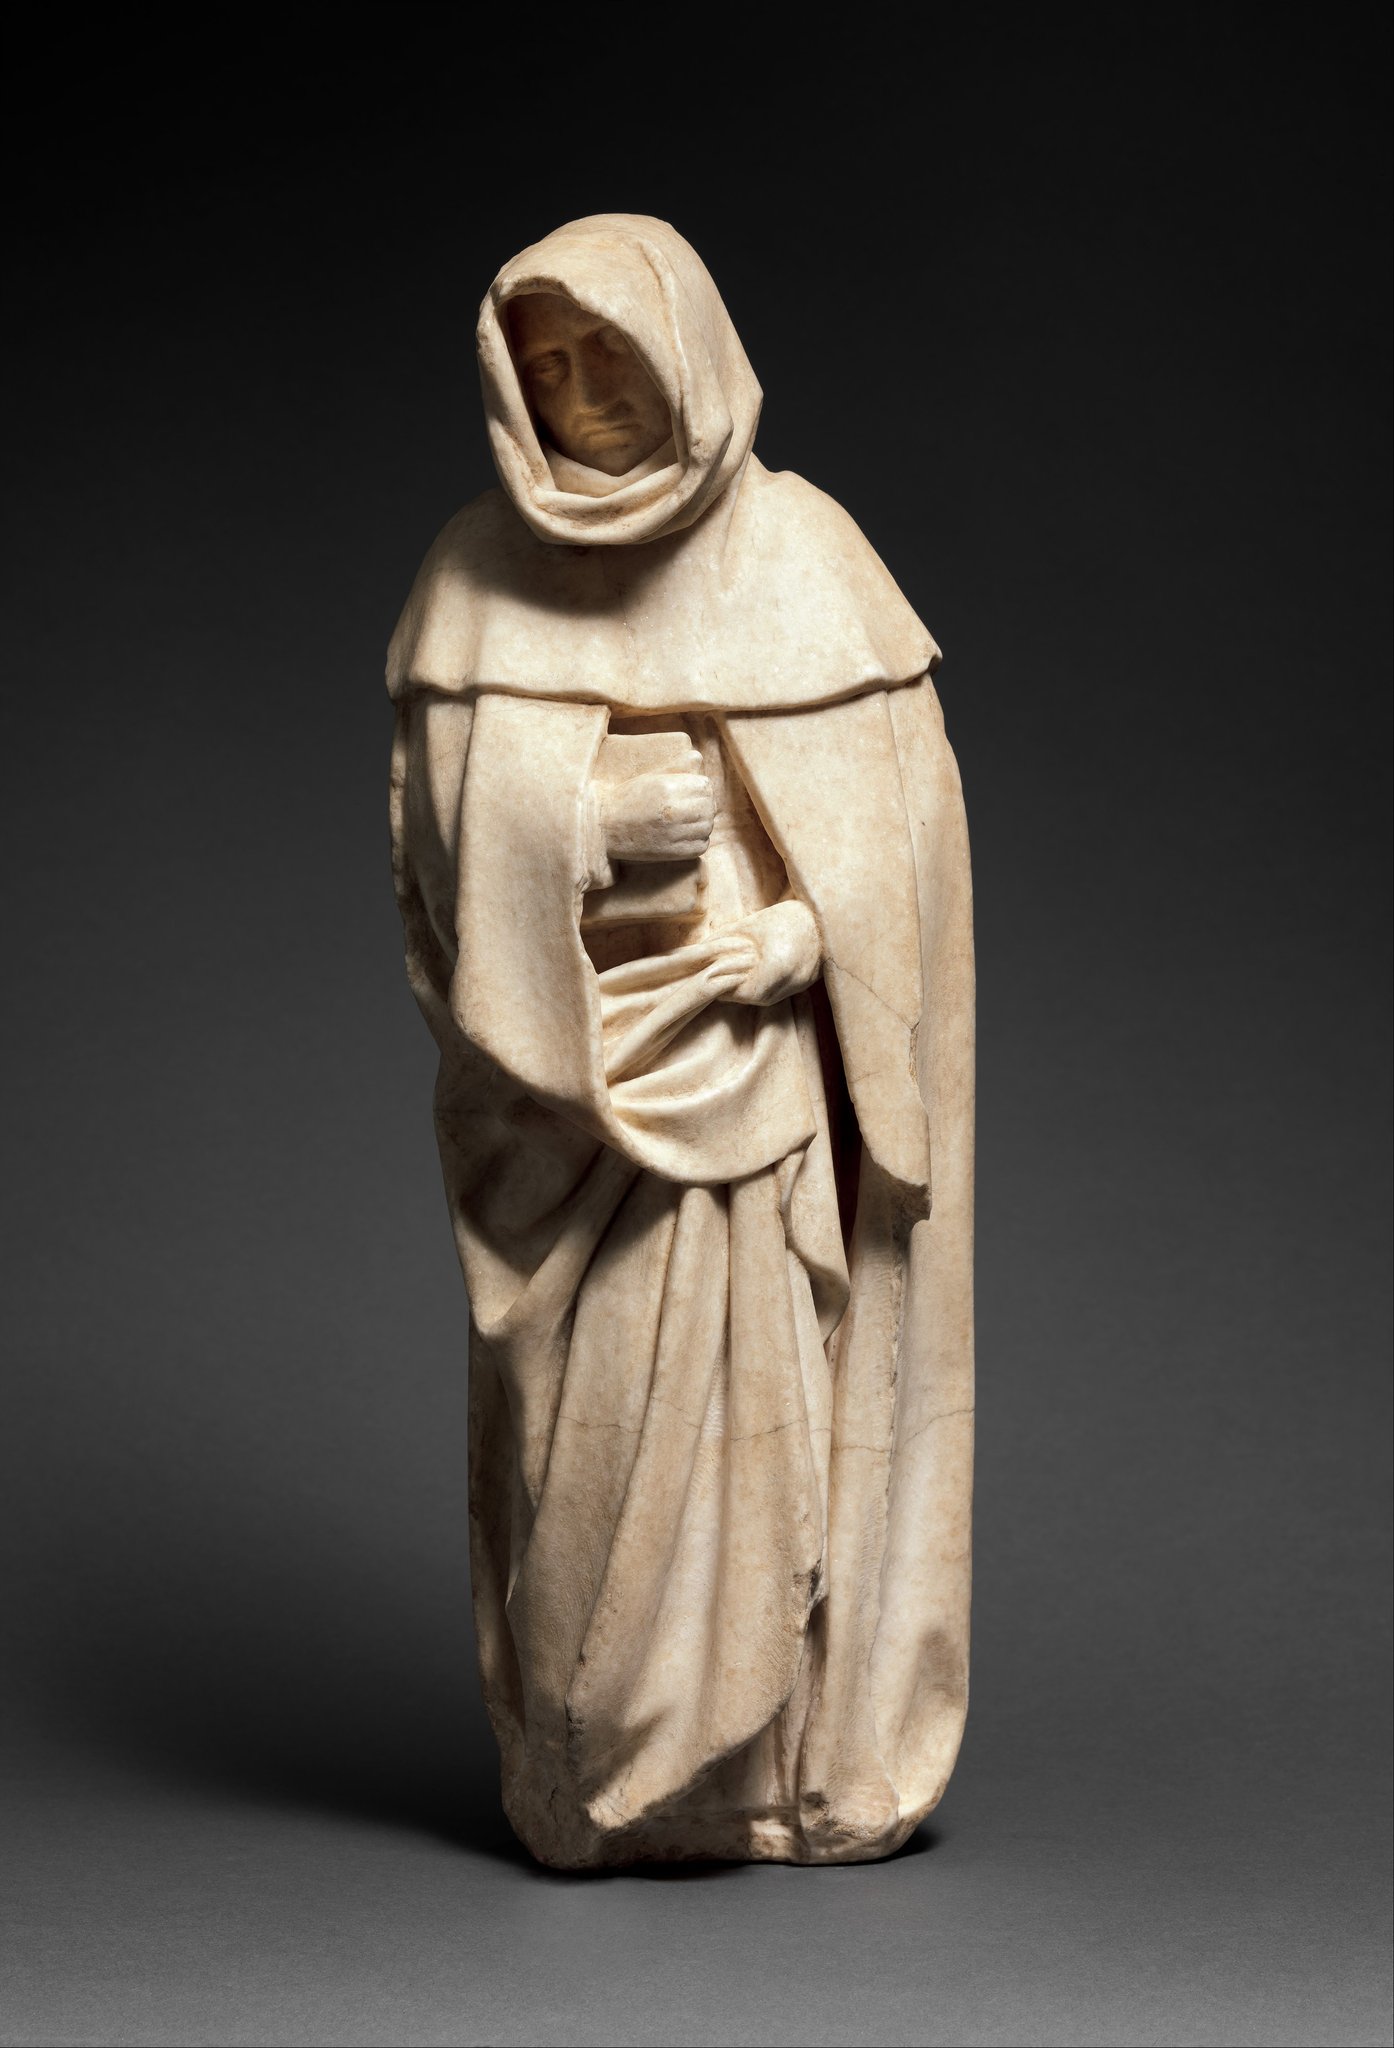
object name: statuette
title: Mourner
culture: french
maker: etienne bobillet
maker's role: artist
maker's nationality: franco-netherlandish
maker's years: 1453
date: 1453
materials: alabaster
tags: human figures,sadness